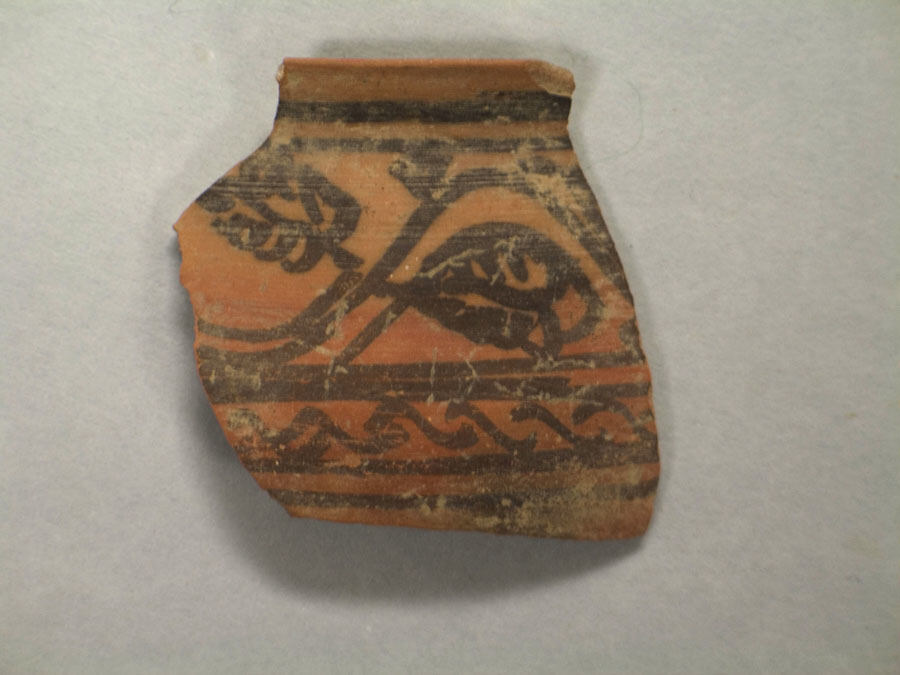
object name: shard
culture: pakistani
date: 301-500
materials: terracotta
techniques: painting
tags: gandhara